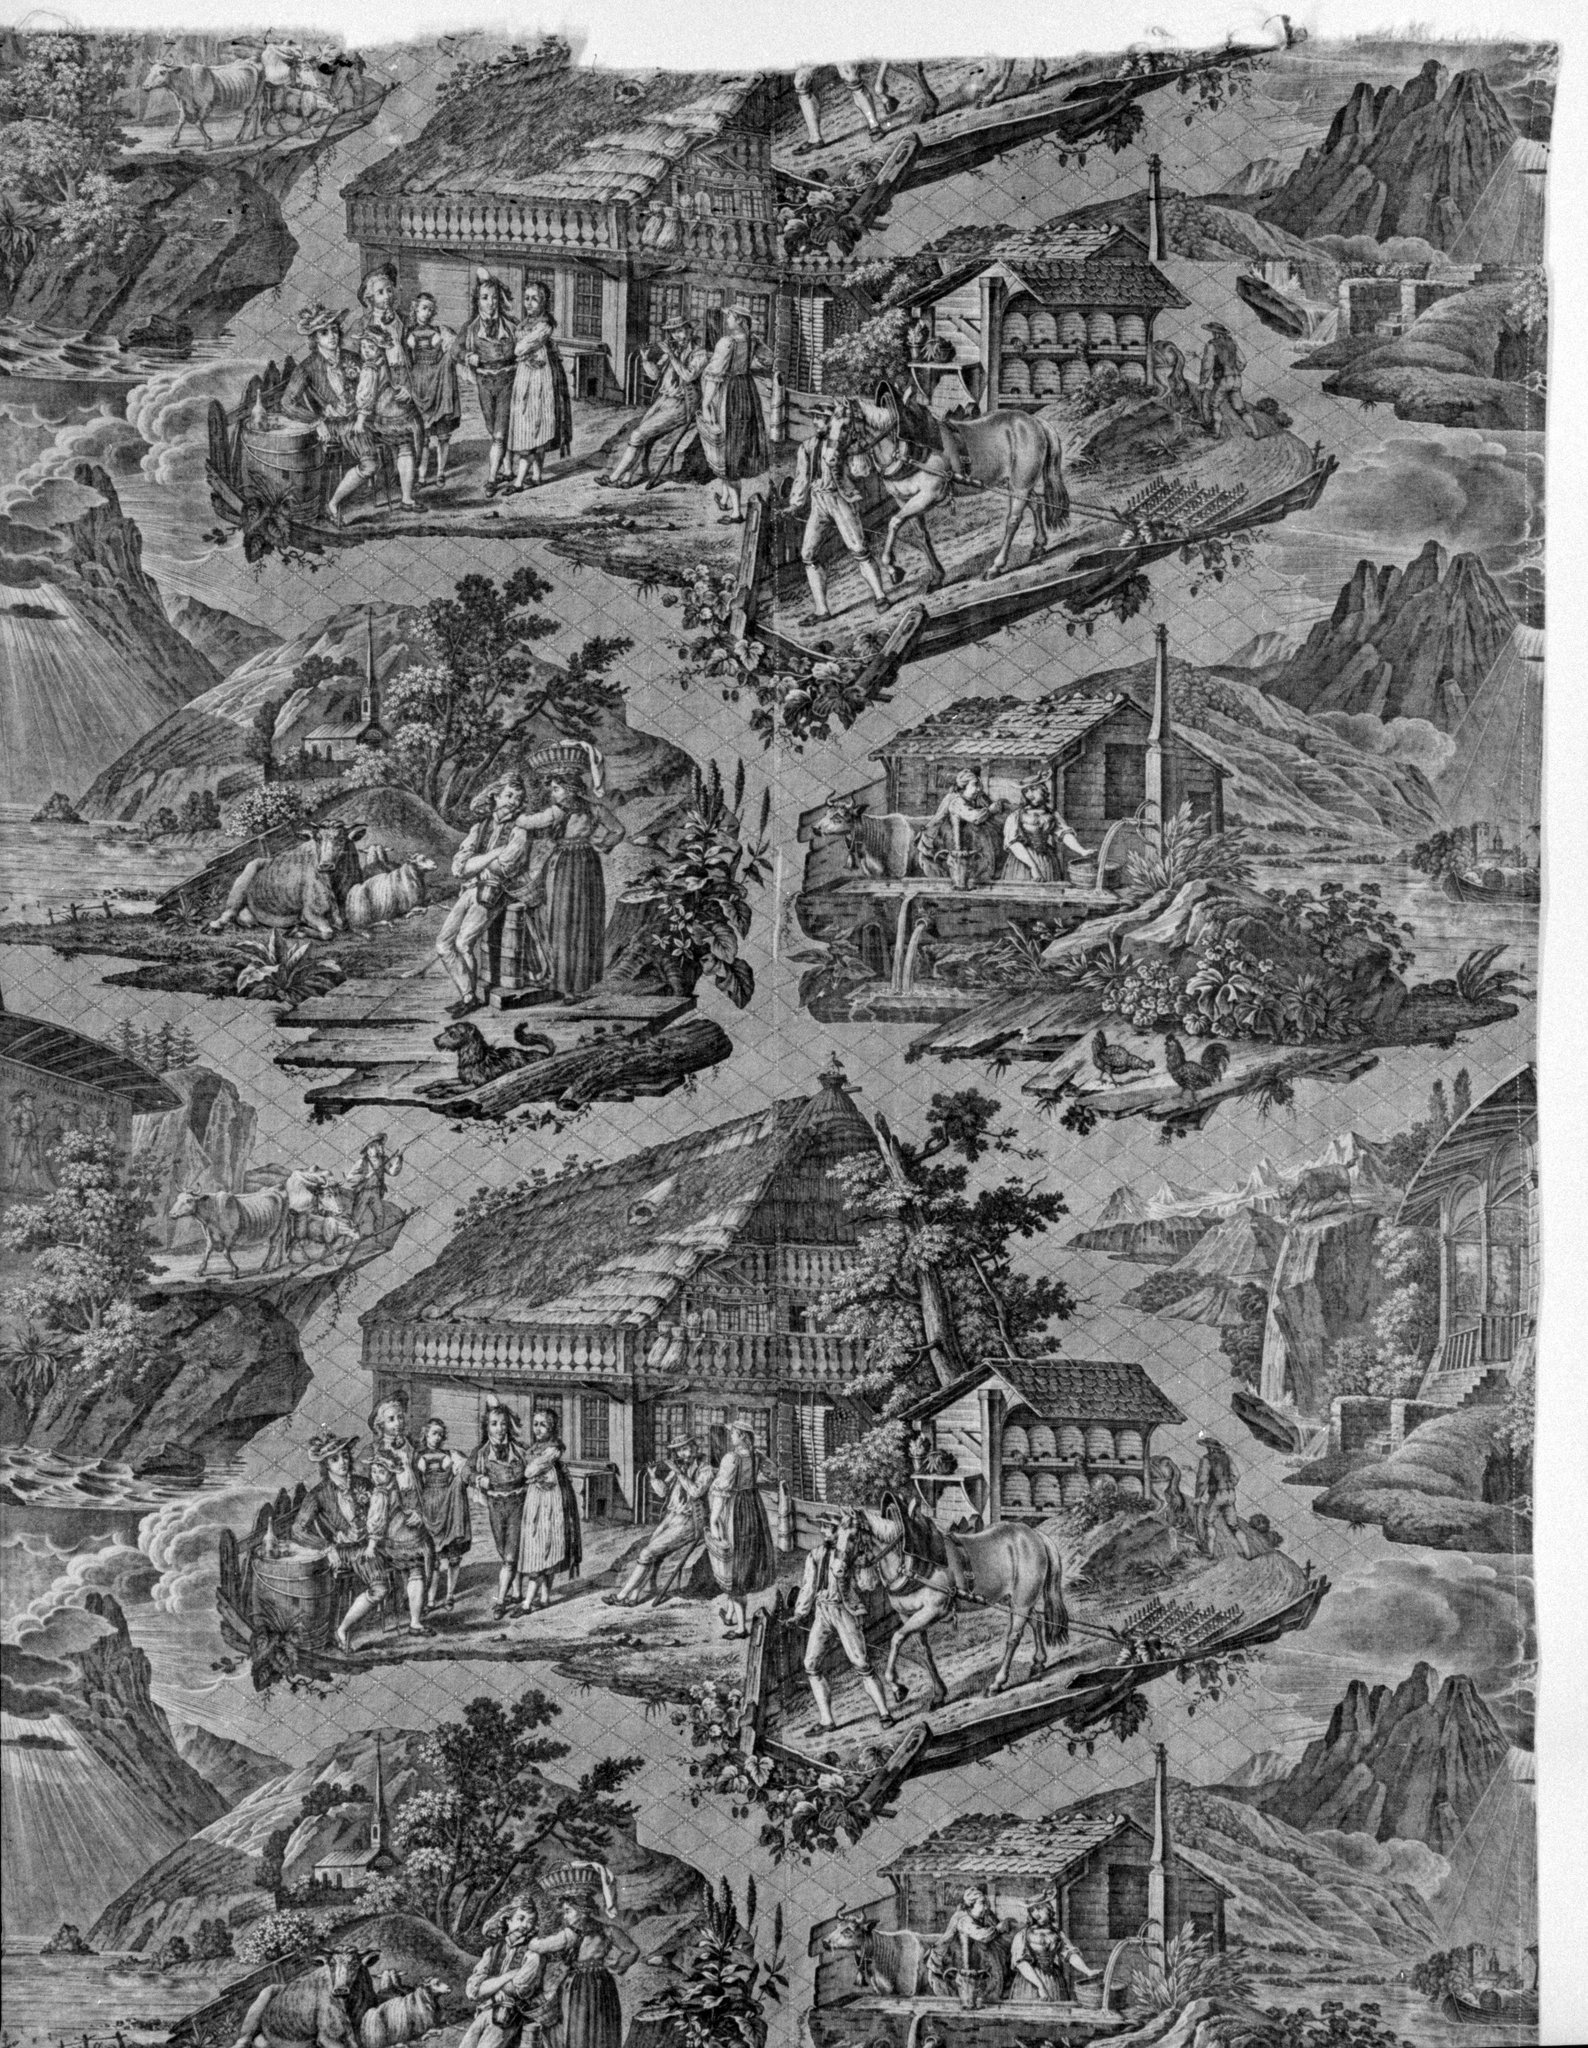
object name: curtain fragment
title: Scenes from "William Tell"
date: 1820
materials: cotton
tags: houses,men,women,horses